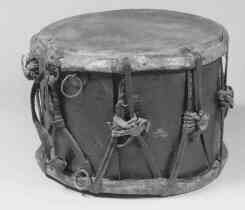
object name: drum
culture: sudanese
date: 1801-1900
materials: metal, wood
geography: sudan